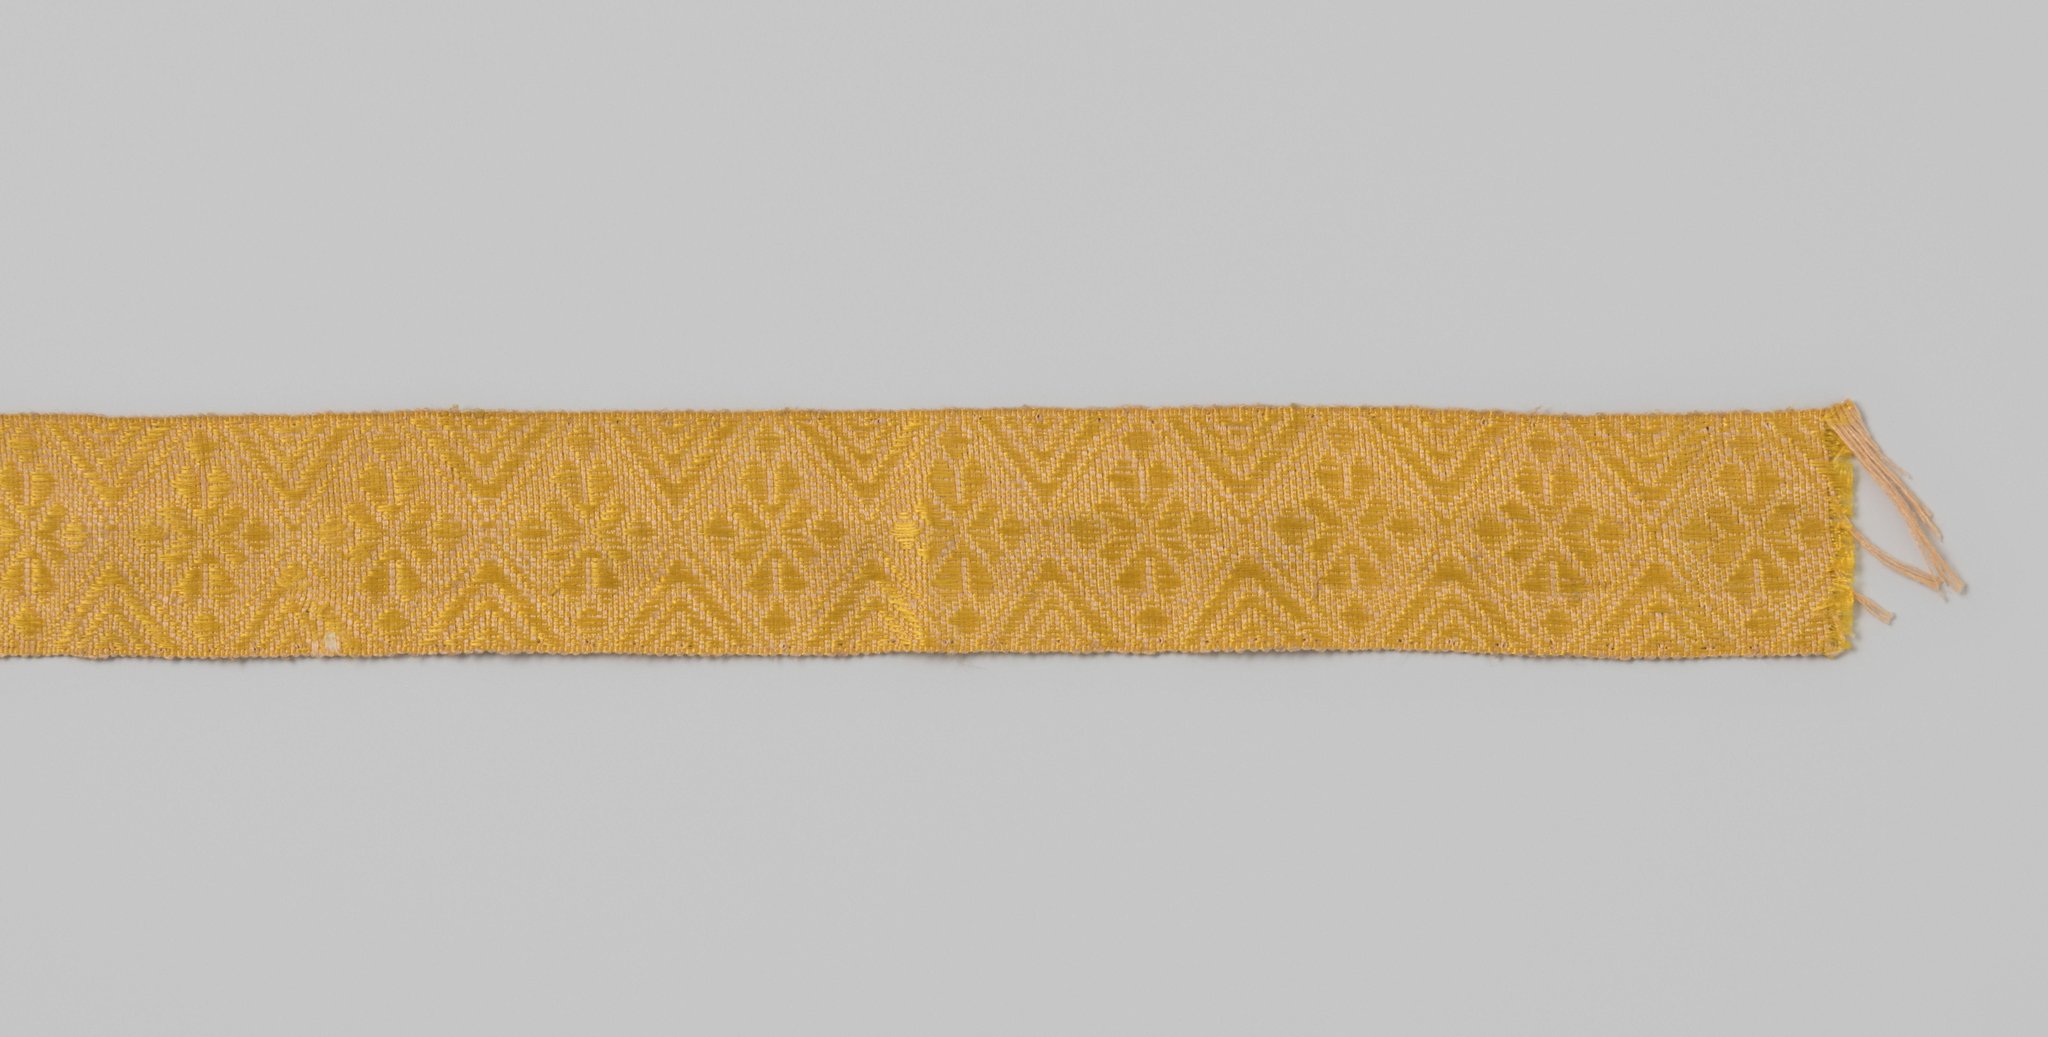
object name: braid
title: Passement van linnen en gele zijde in complex ruitpatroon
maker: Anonymous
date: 1700-1899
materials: linen, silk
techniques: weave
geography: europe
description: Passement van linnen en gele zijde in een complex ruitpatroon, met in het midden hiervan een patroon dat bestaat uit vier hartvormige figuren.